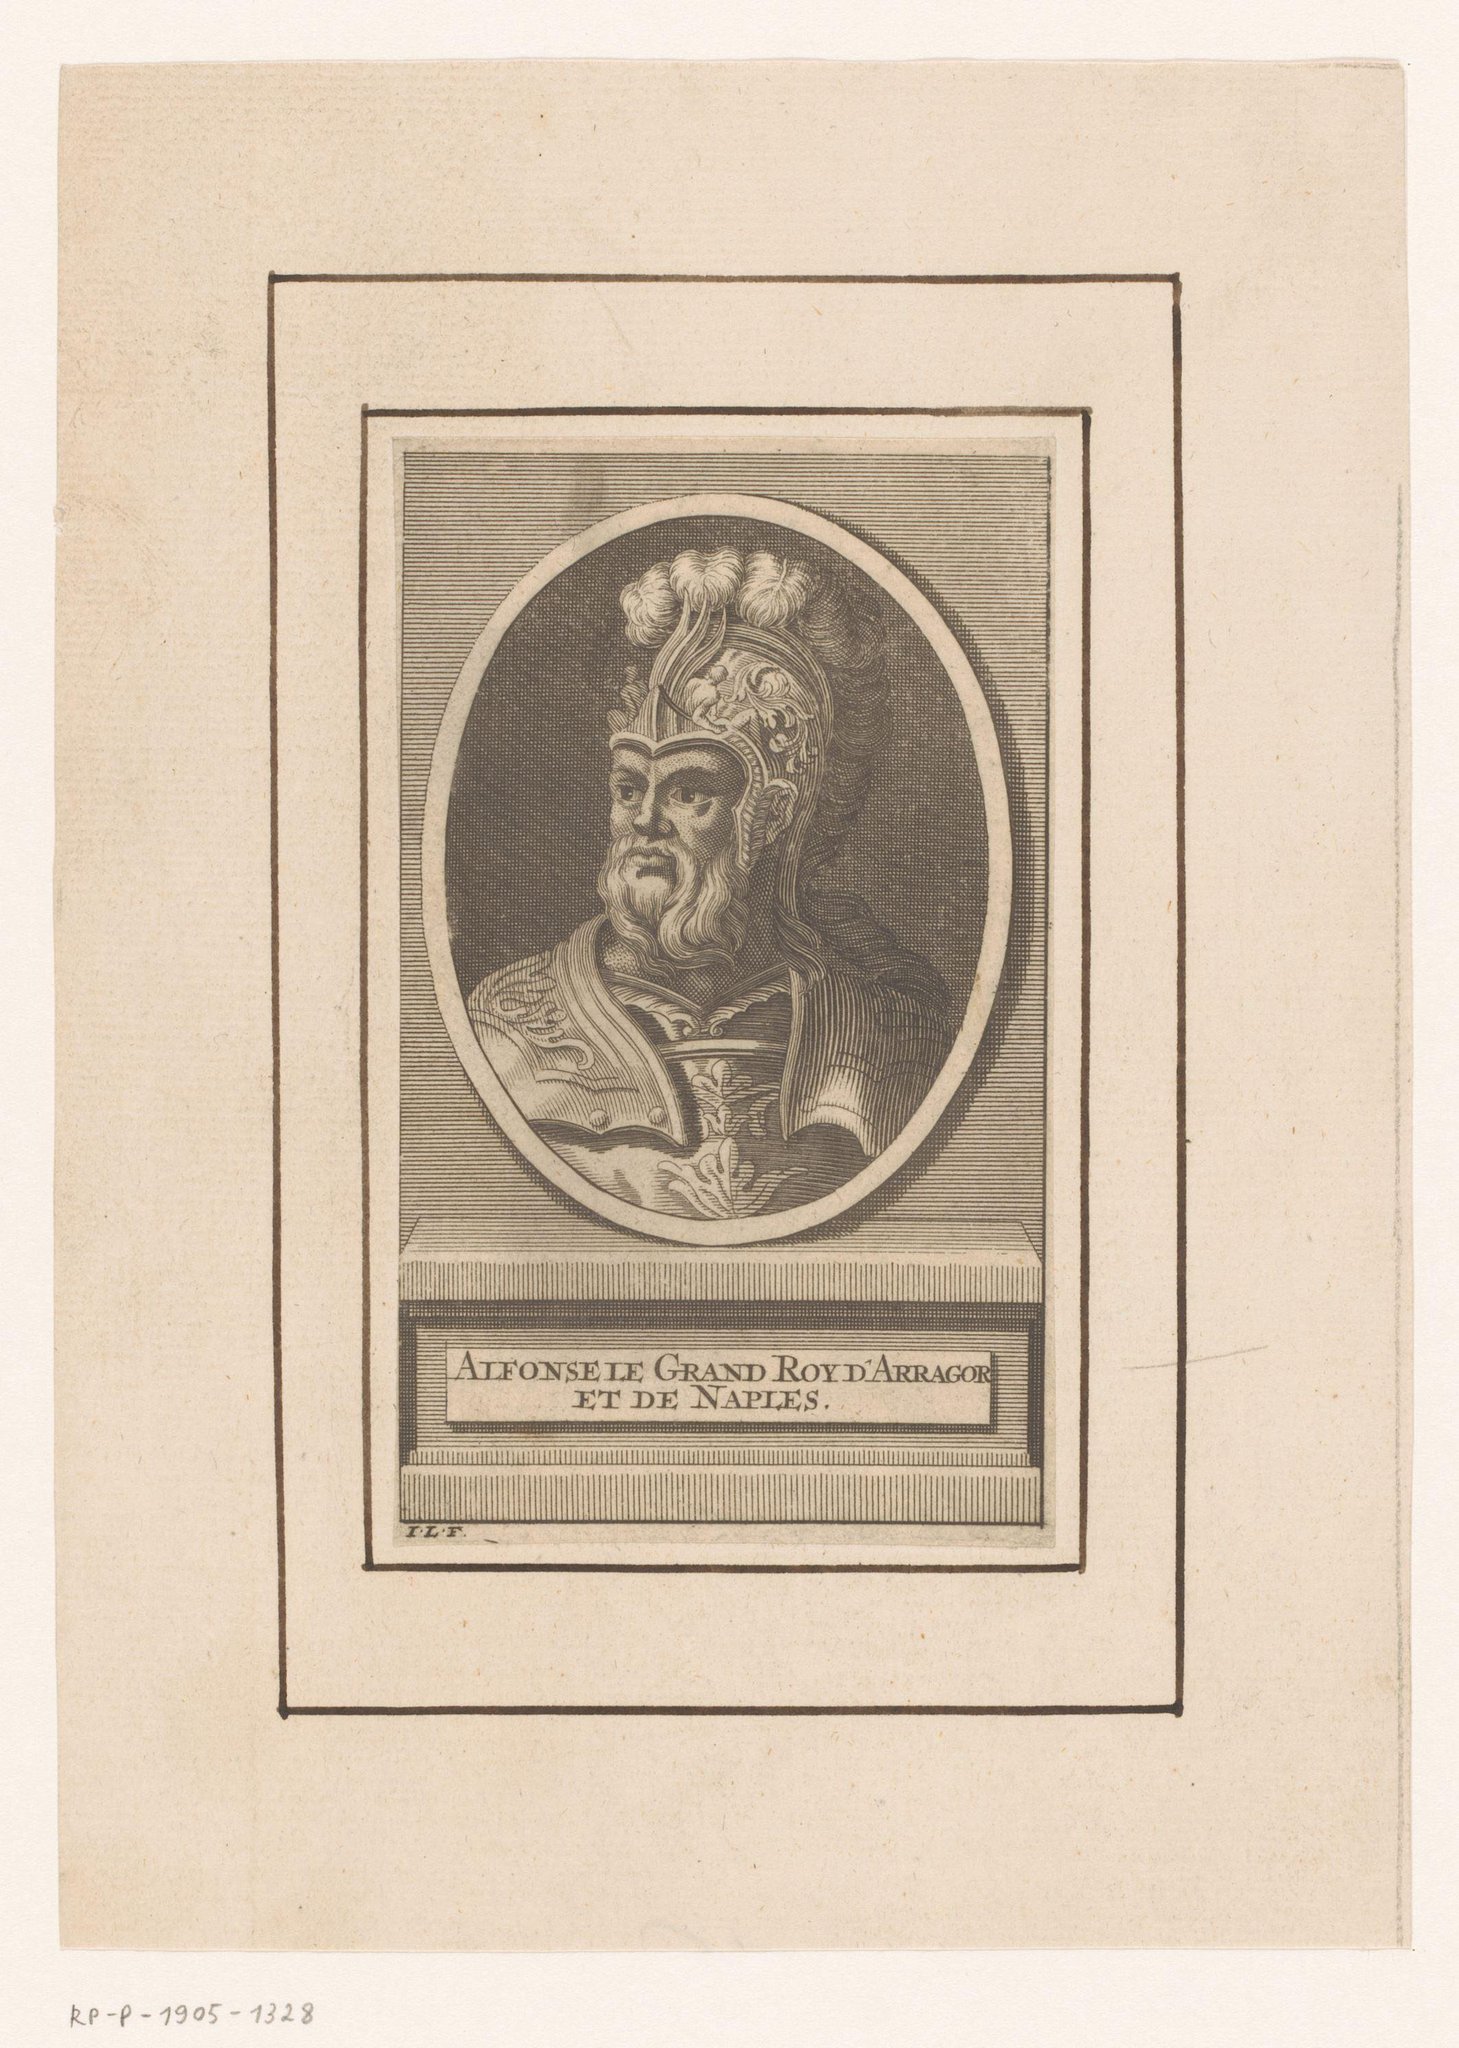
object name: print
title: Portret, mogelijk van Alfons V van Aragón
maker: monogrammist il (graveur)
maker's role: print maker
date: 1640-1700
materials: paper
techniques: engraving, etching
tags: naples, historical persons, king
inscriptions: collector's mark: Lugt 2228